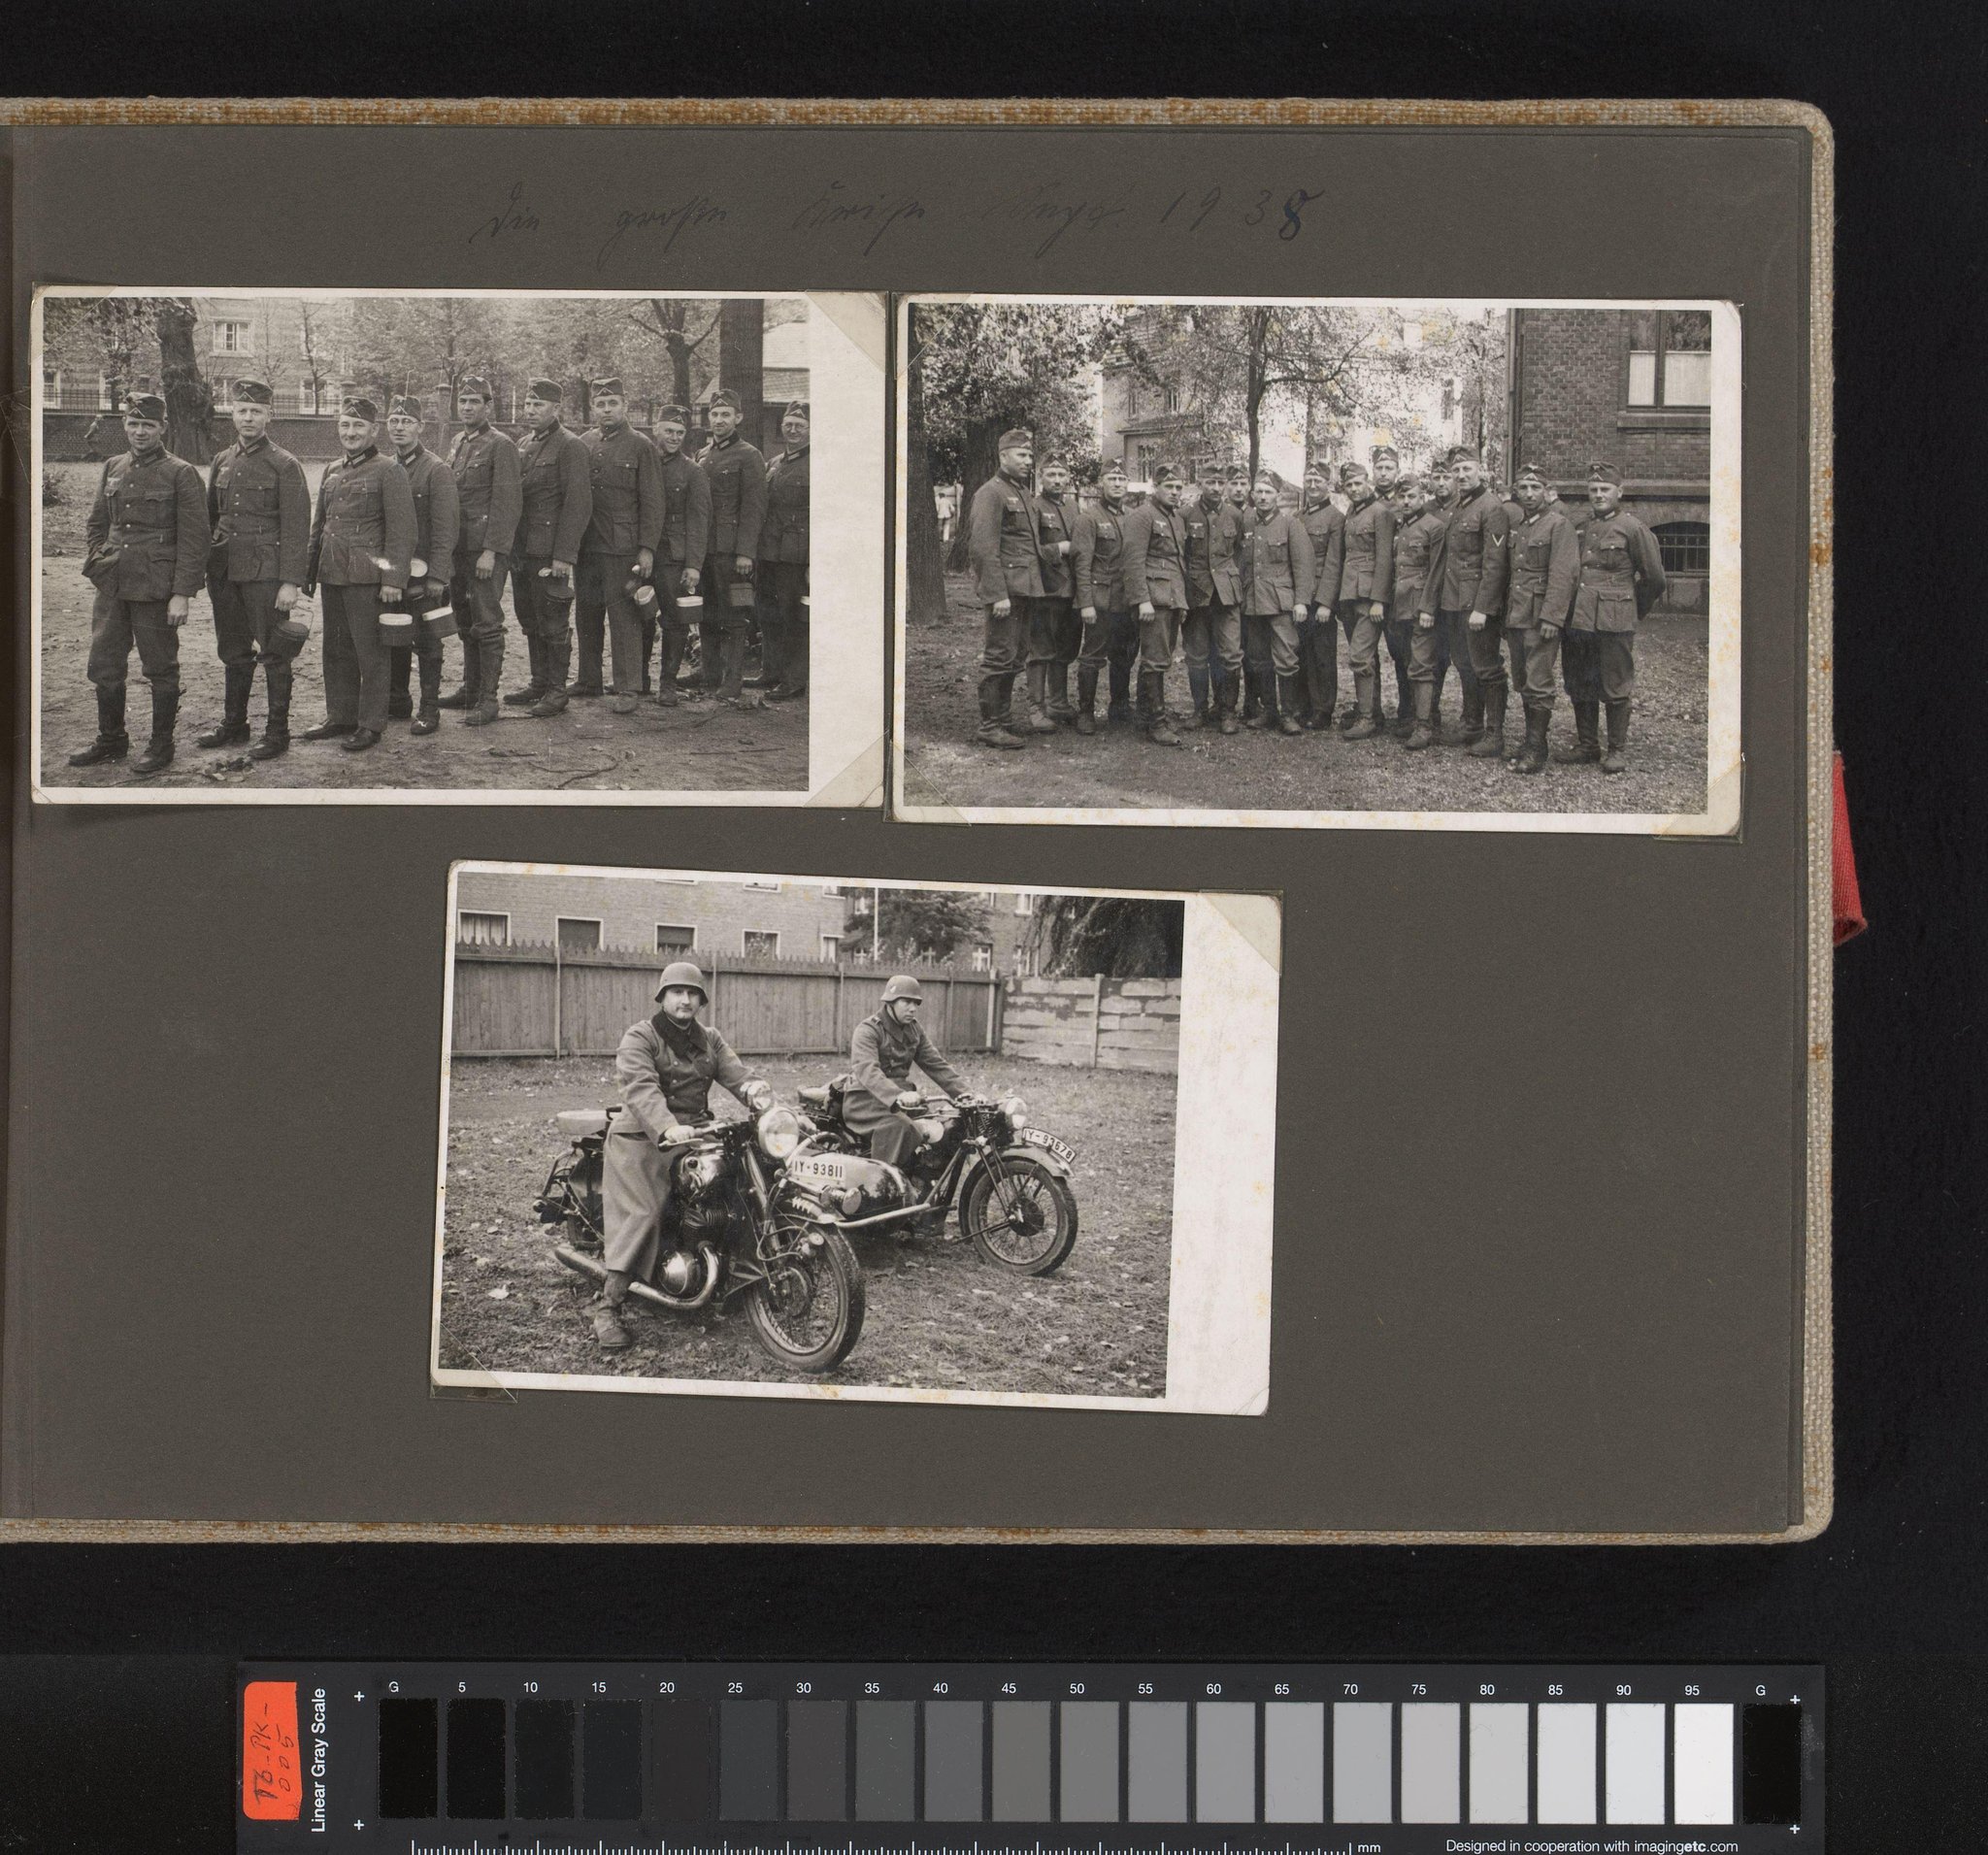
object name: album leaf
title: Groepsfoto's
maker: unverdross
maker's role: fotograaf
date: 1909-1938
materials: cardboard, photographic support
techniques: gelatin silver print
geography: wesel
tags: the company, the unit, the troop ~ military service, motor-cycles and other two-wheeled motor-vehicles, modern forms of military vehicles, germany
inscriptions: date: ‘28/IX 38’, inscription: ‘Ein ... 1938’, name: ‘Photo Unverdross, Wesel’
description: Albumblad met twee groepsfoto's van de eenheid en van twee militairen op de motor, 1938. Onderdeel van de fotoalbum van de Wehrmacht 1938-1941.